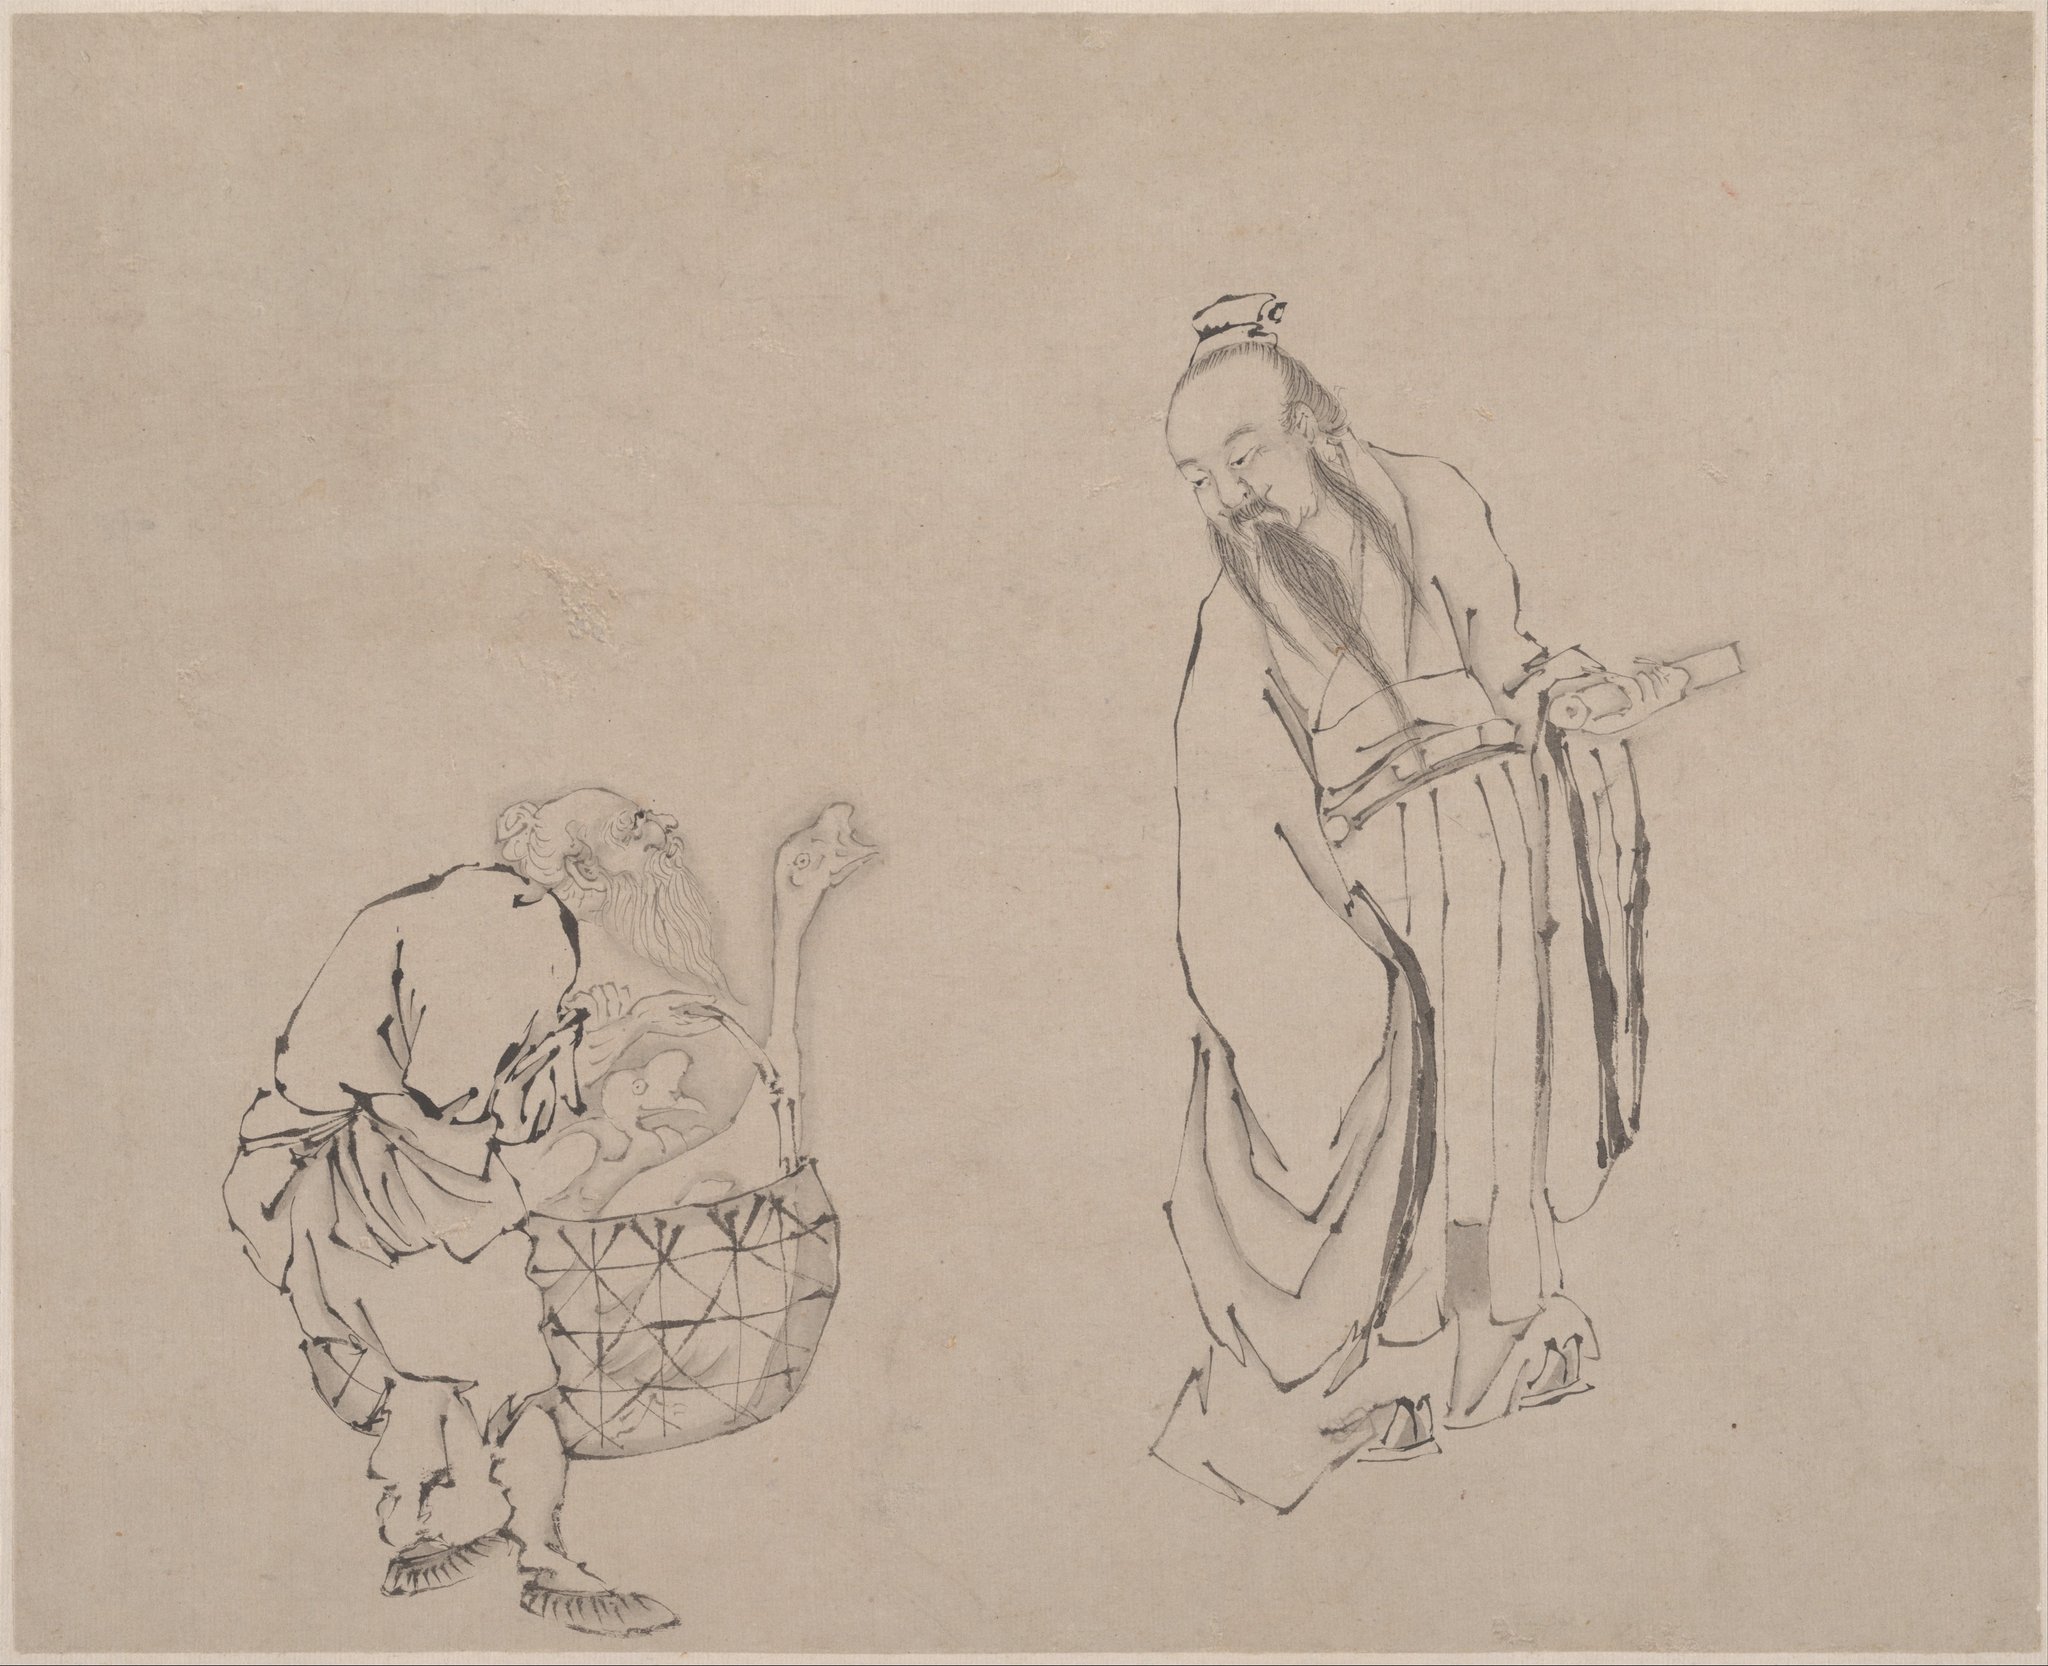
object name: album leaf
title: Painting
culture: chinese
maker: unidentified artist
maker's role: artist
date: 1901-2000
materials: ink, paper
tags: geese,men